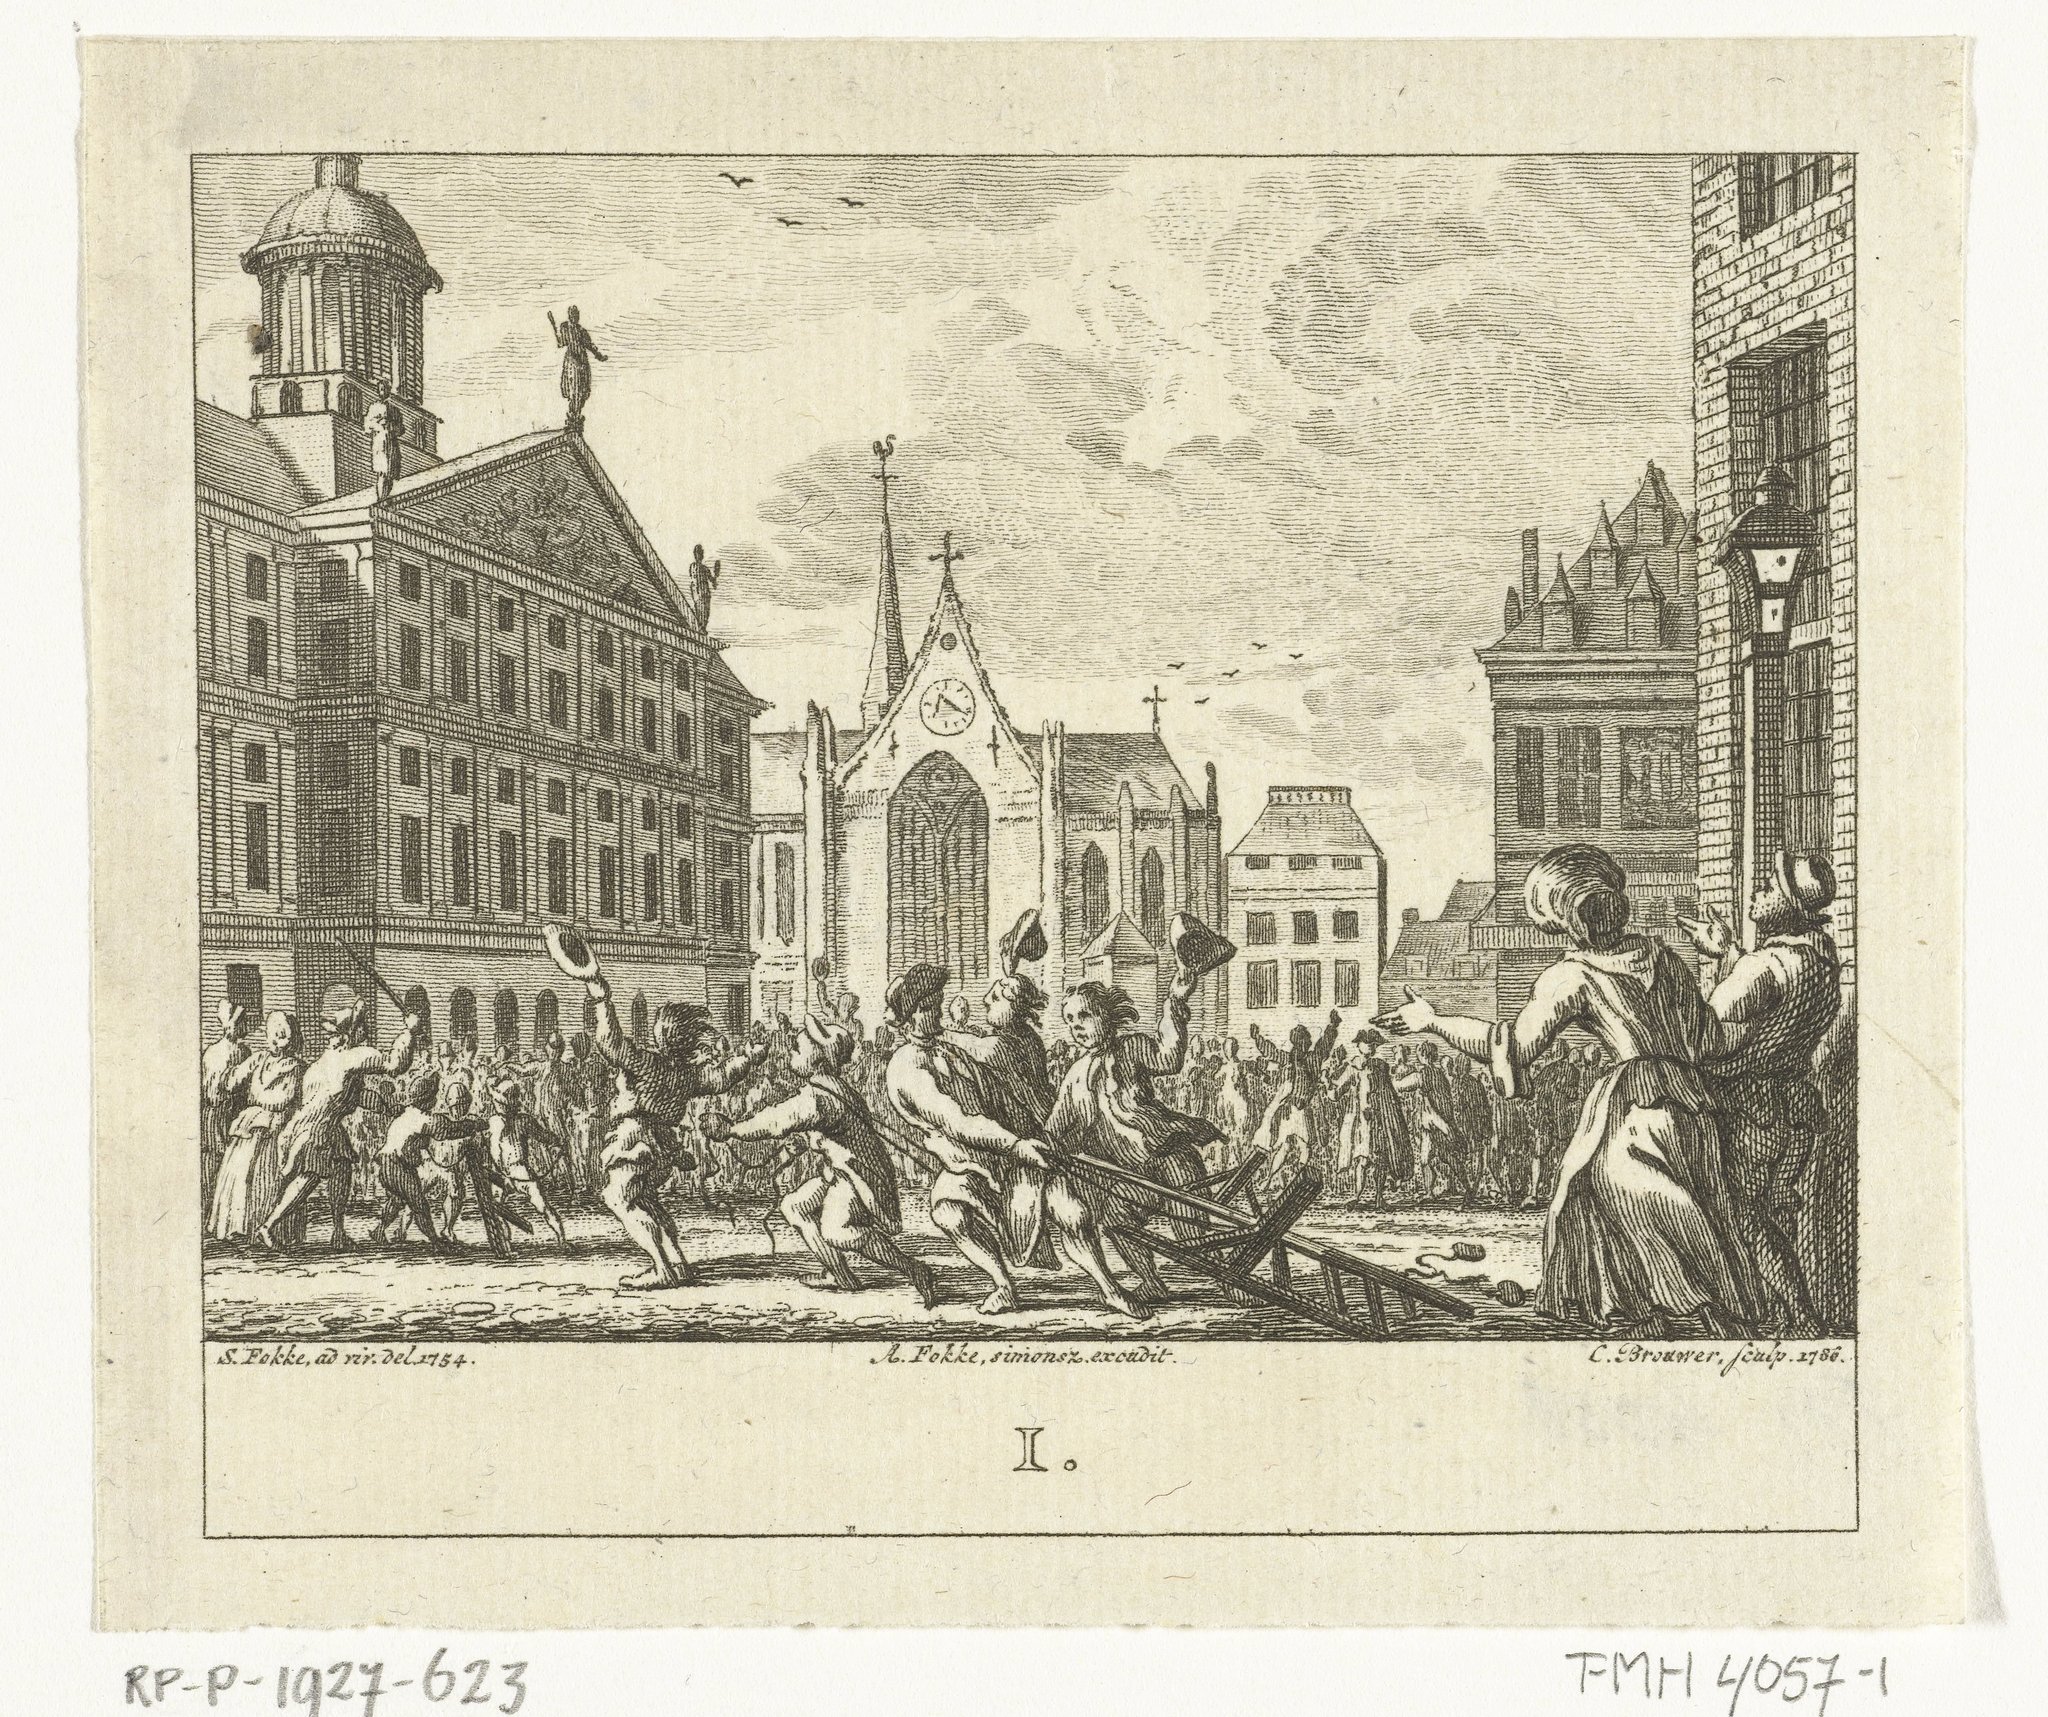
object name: print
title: Opstand bij de begrafenis van Daniël Raap op de Dam te Amsterdam in 1754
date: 1786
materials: paper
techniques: etching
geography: netherlands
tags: funerary ceremonial, street-fights, riots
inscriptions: collector's mark: Lugt 2228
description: Gebruikt als illustratie in: Arend Fokke Simonsz. De vaderlandsche historie in themata. Amsterdam: Arend Fokke Simonsz., edities tussen 1783-ca. 1792. Daarbij zijn vier illustraties met de gebeurtenissen rond de begrafenis van Raap opgenomen, deze zijn genummerd 1 t/m 4.